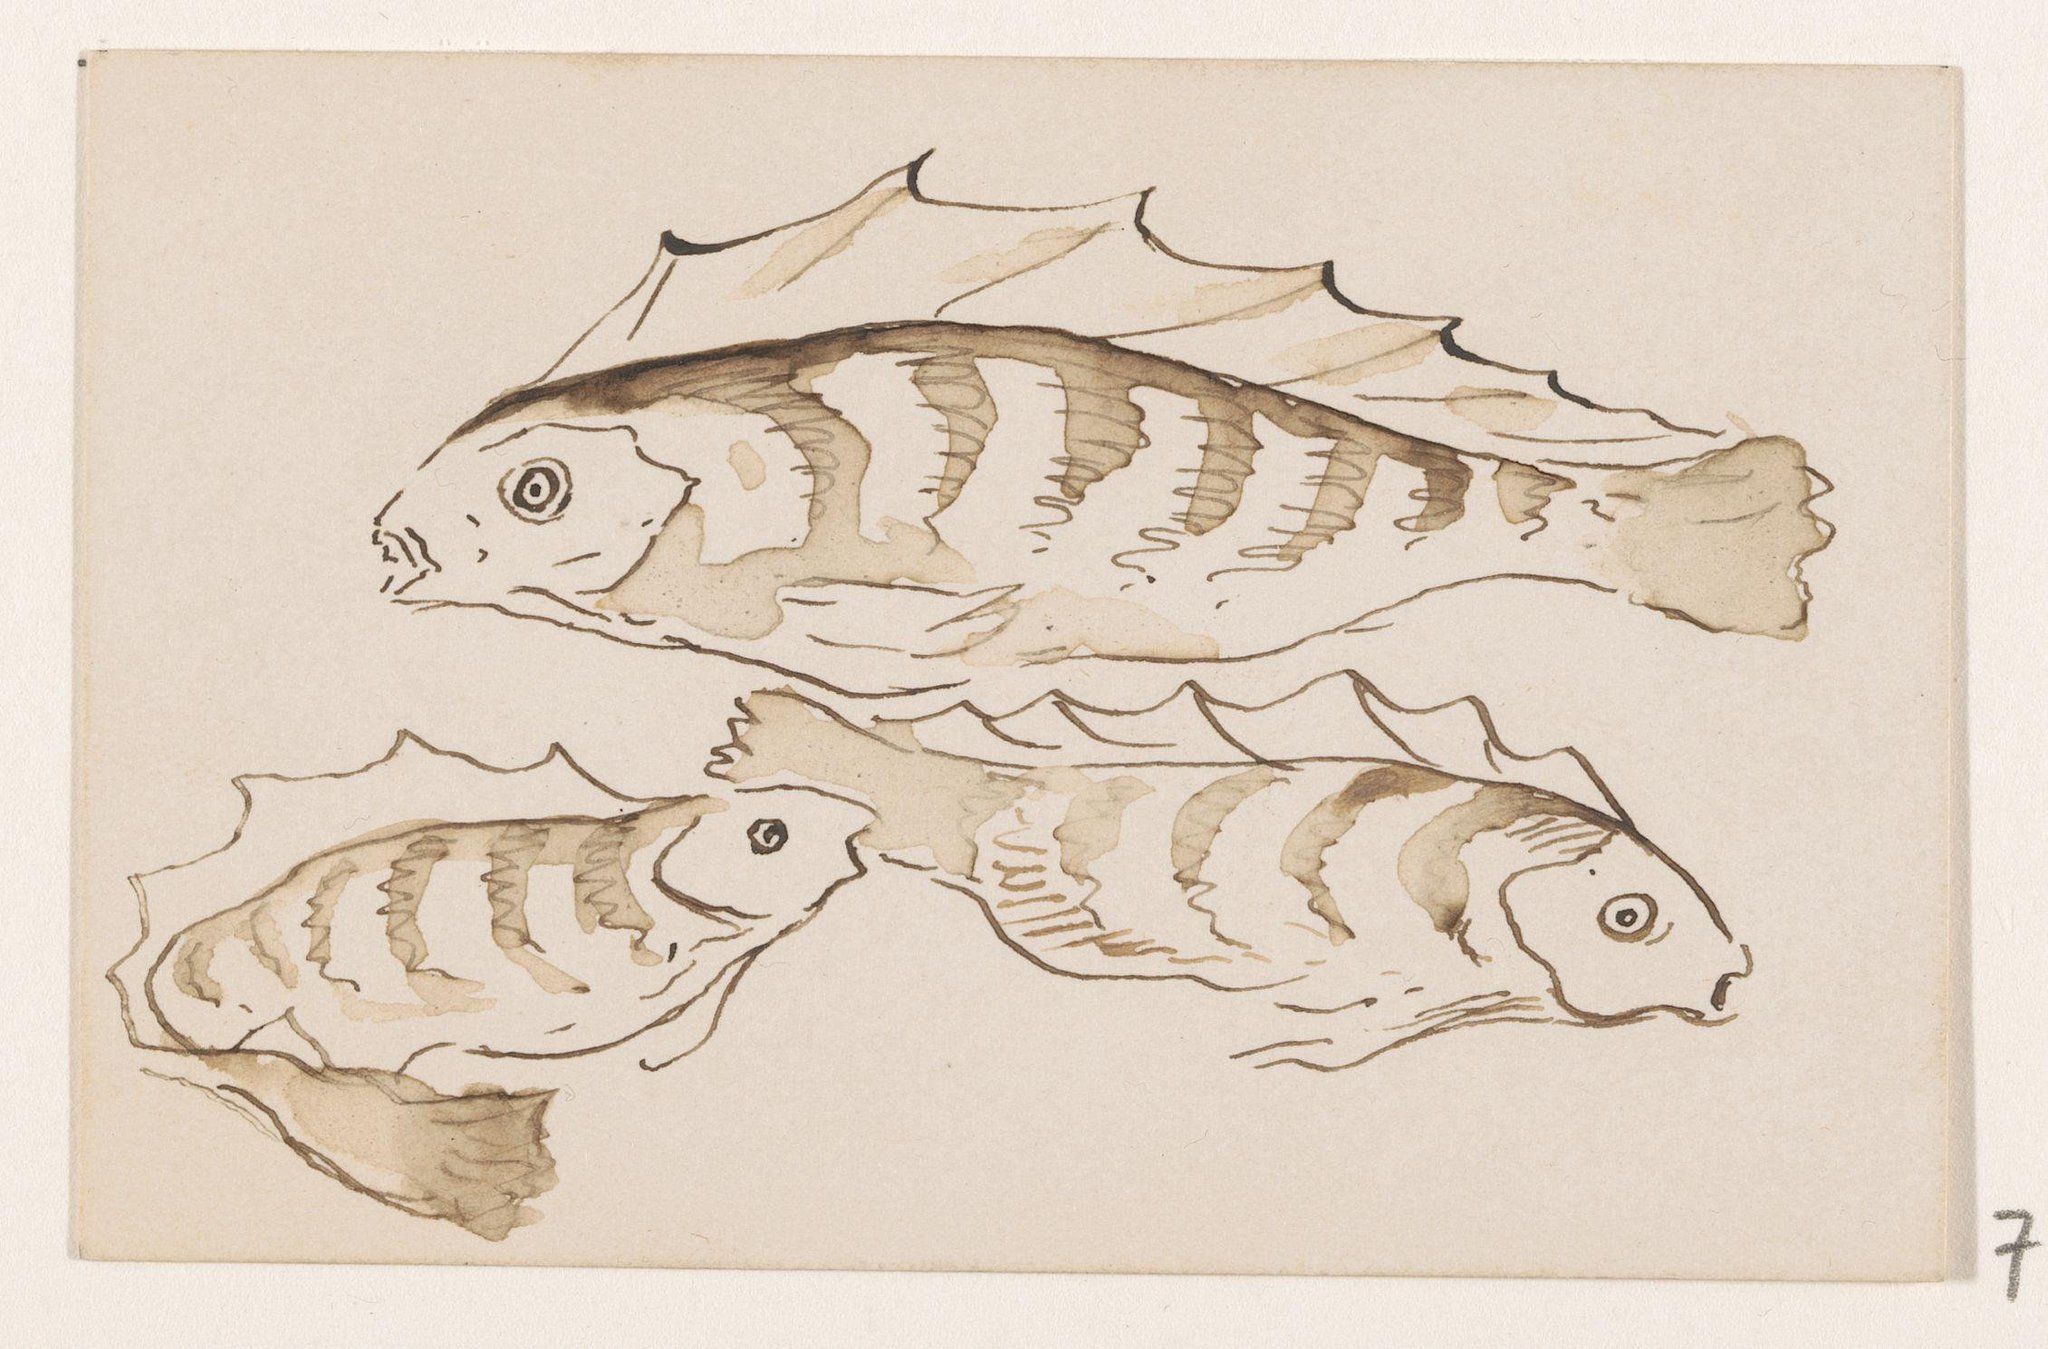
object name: visiting card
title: Drie baarzen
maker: johannes tavenraat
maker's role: draughtsman, painter, print maker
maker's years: 1809-1881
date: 1840-1880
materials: ink, paper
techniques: brush, pen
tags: bony fishes: perch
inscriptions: collector's mark: Lugt 2228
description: Drie baarzen. Getekend op de achterzijde van een visitekaartje van 'Gebr.s Canta'.